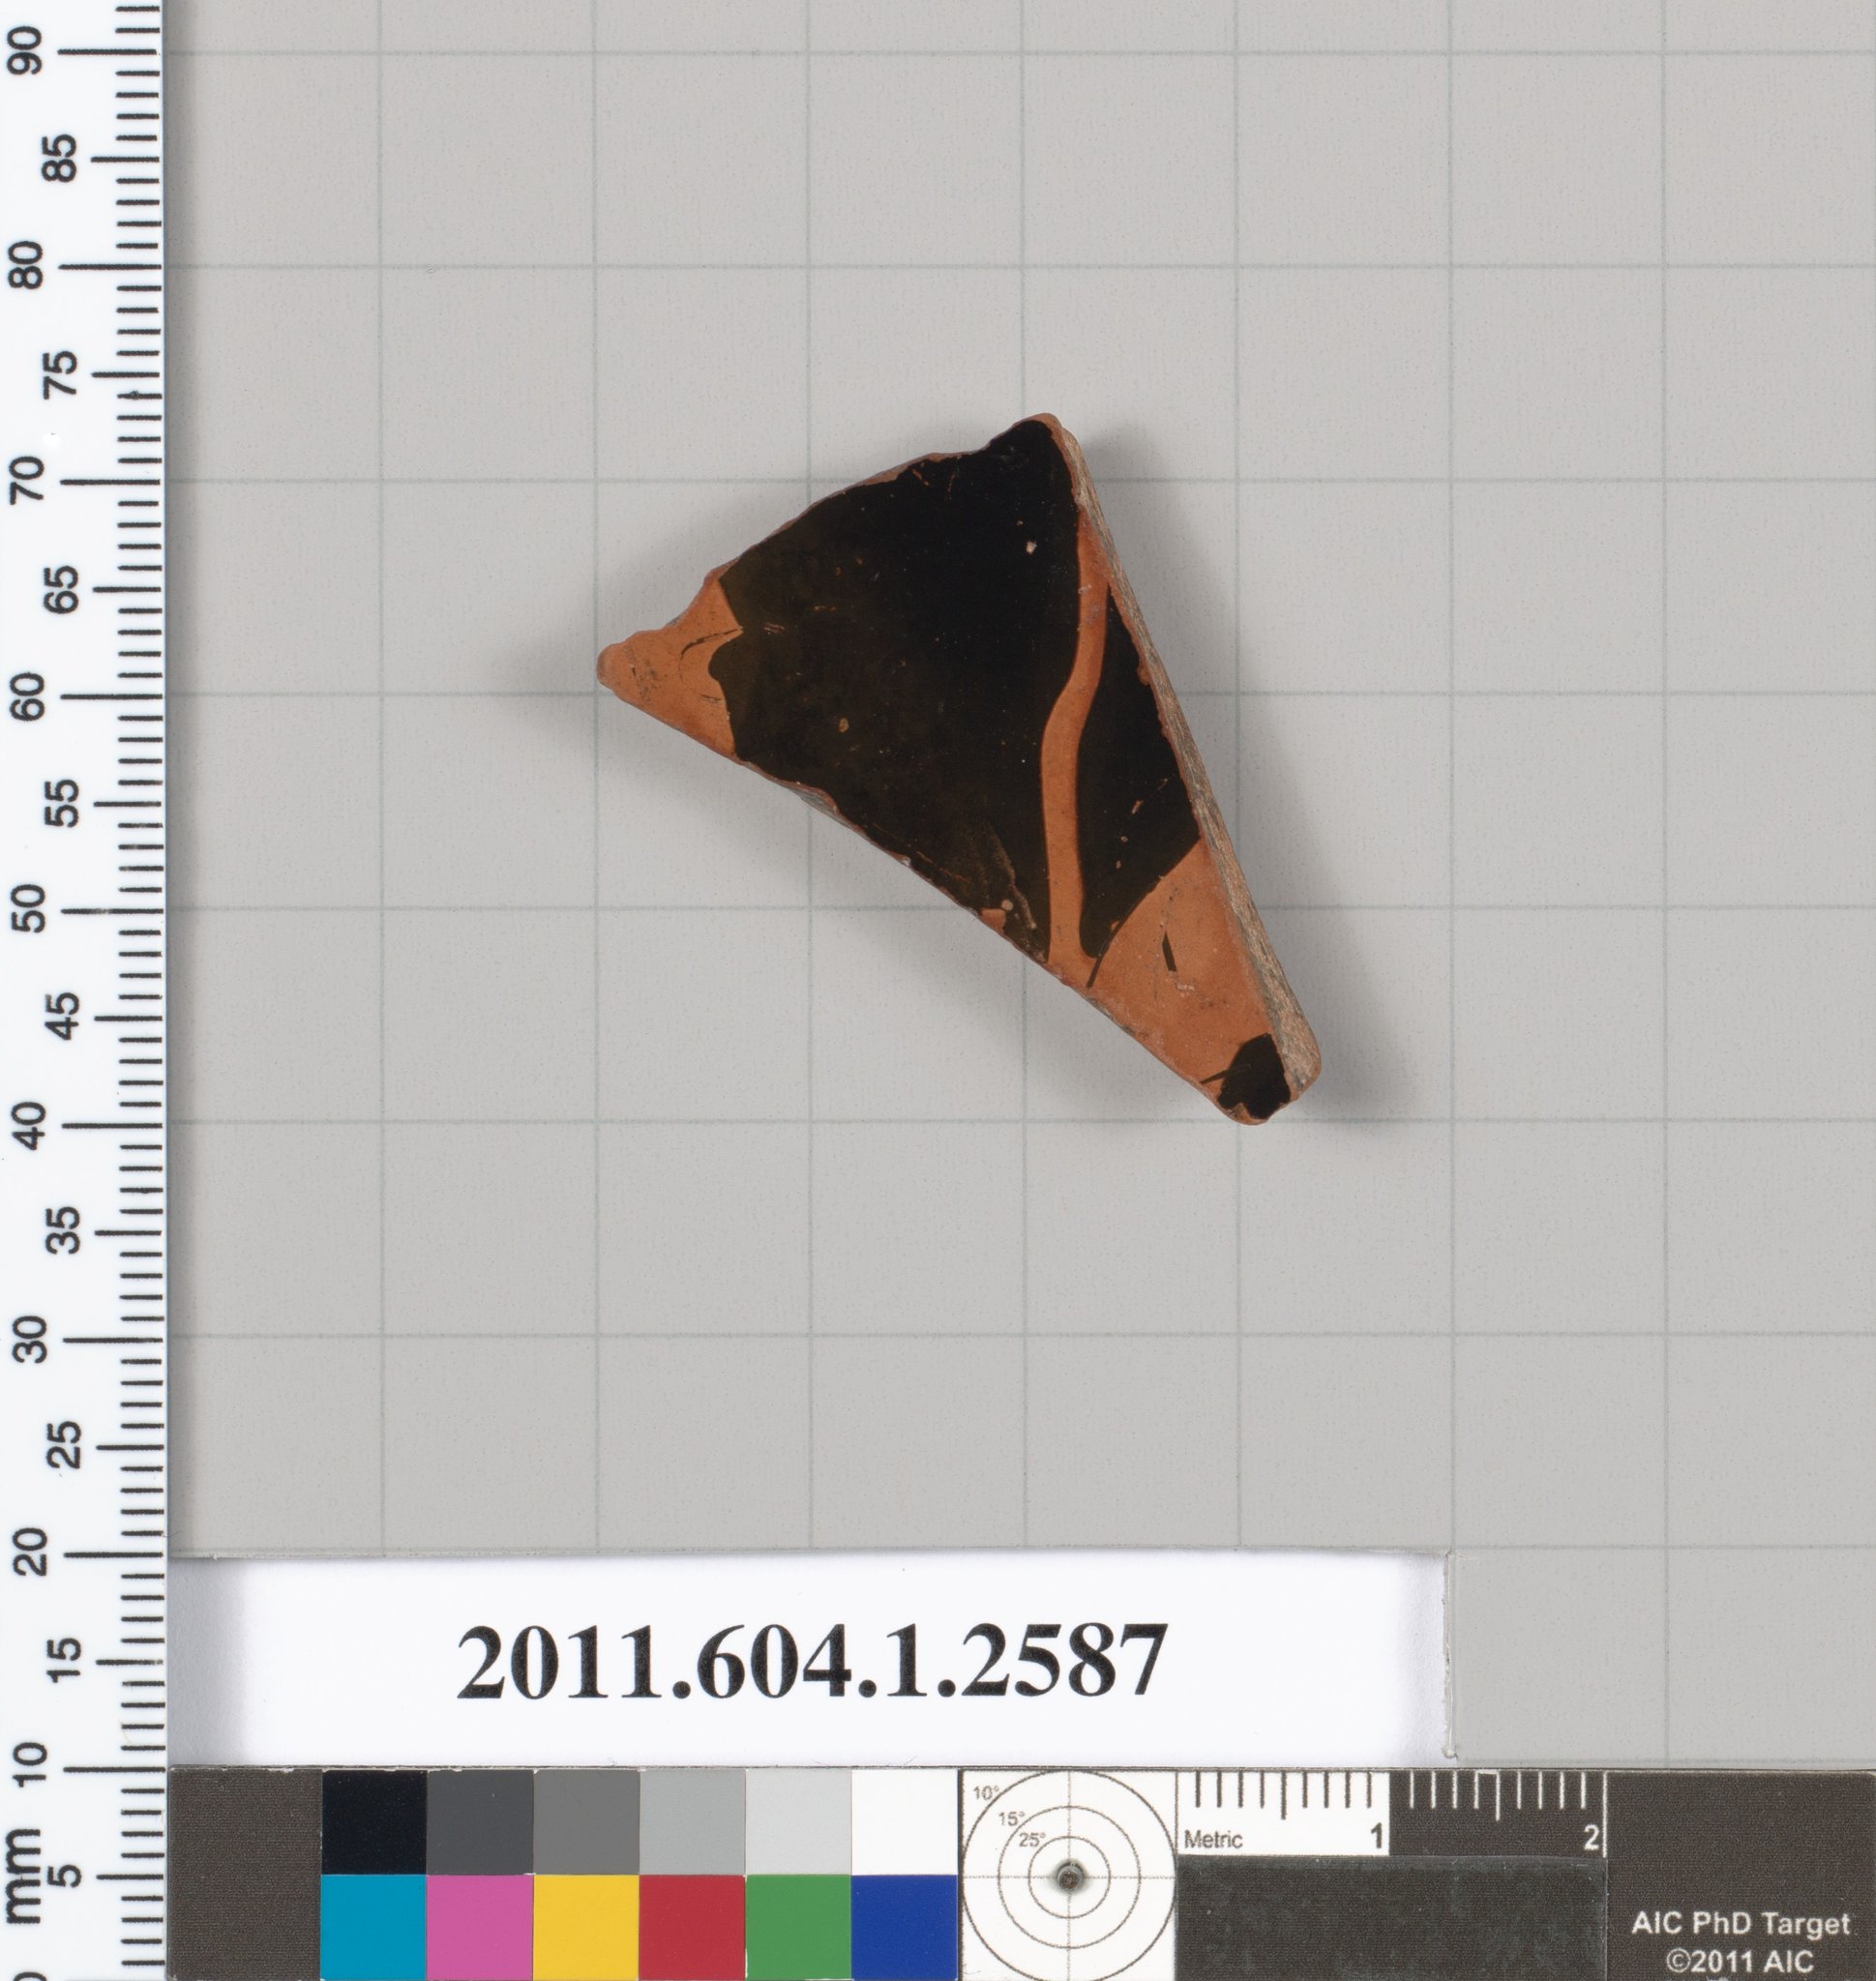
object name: kylix fragment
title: Terracotta fragment of a kylix (drinking cup)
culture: greek, attic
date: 475-451 BCE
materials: terracotta